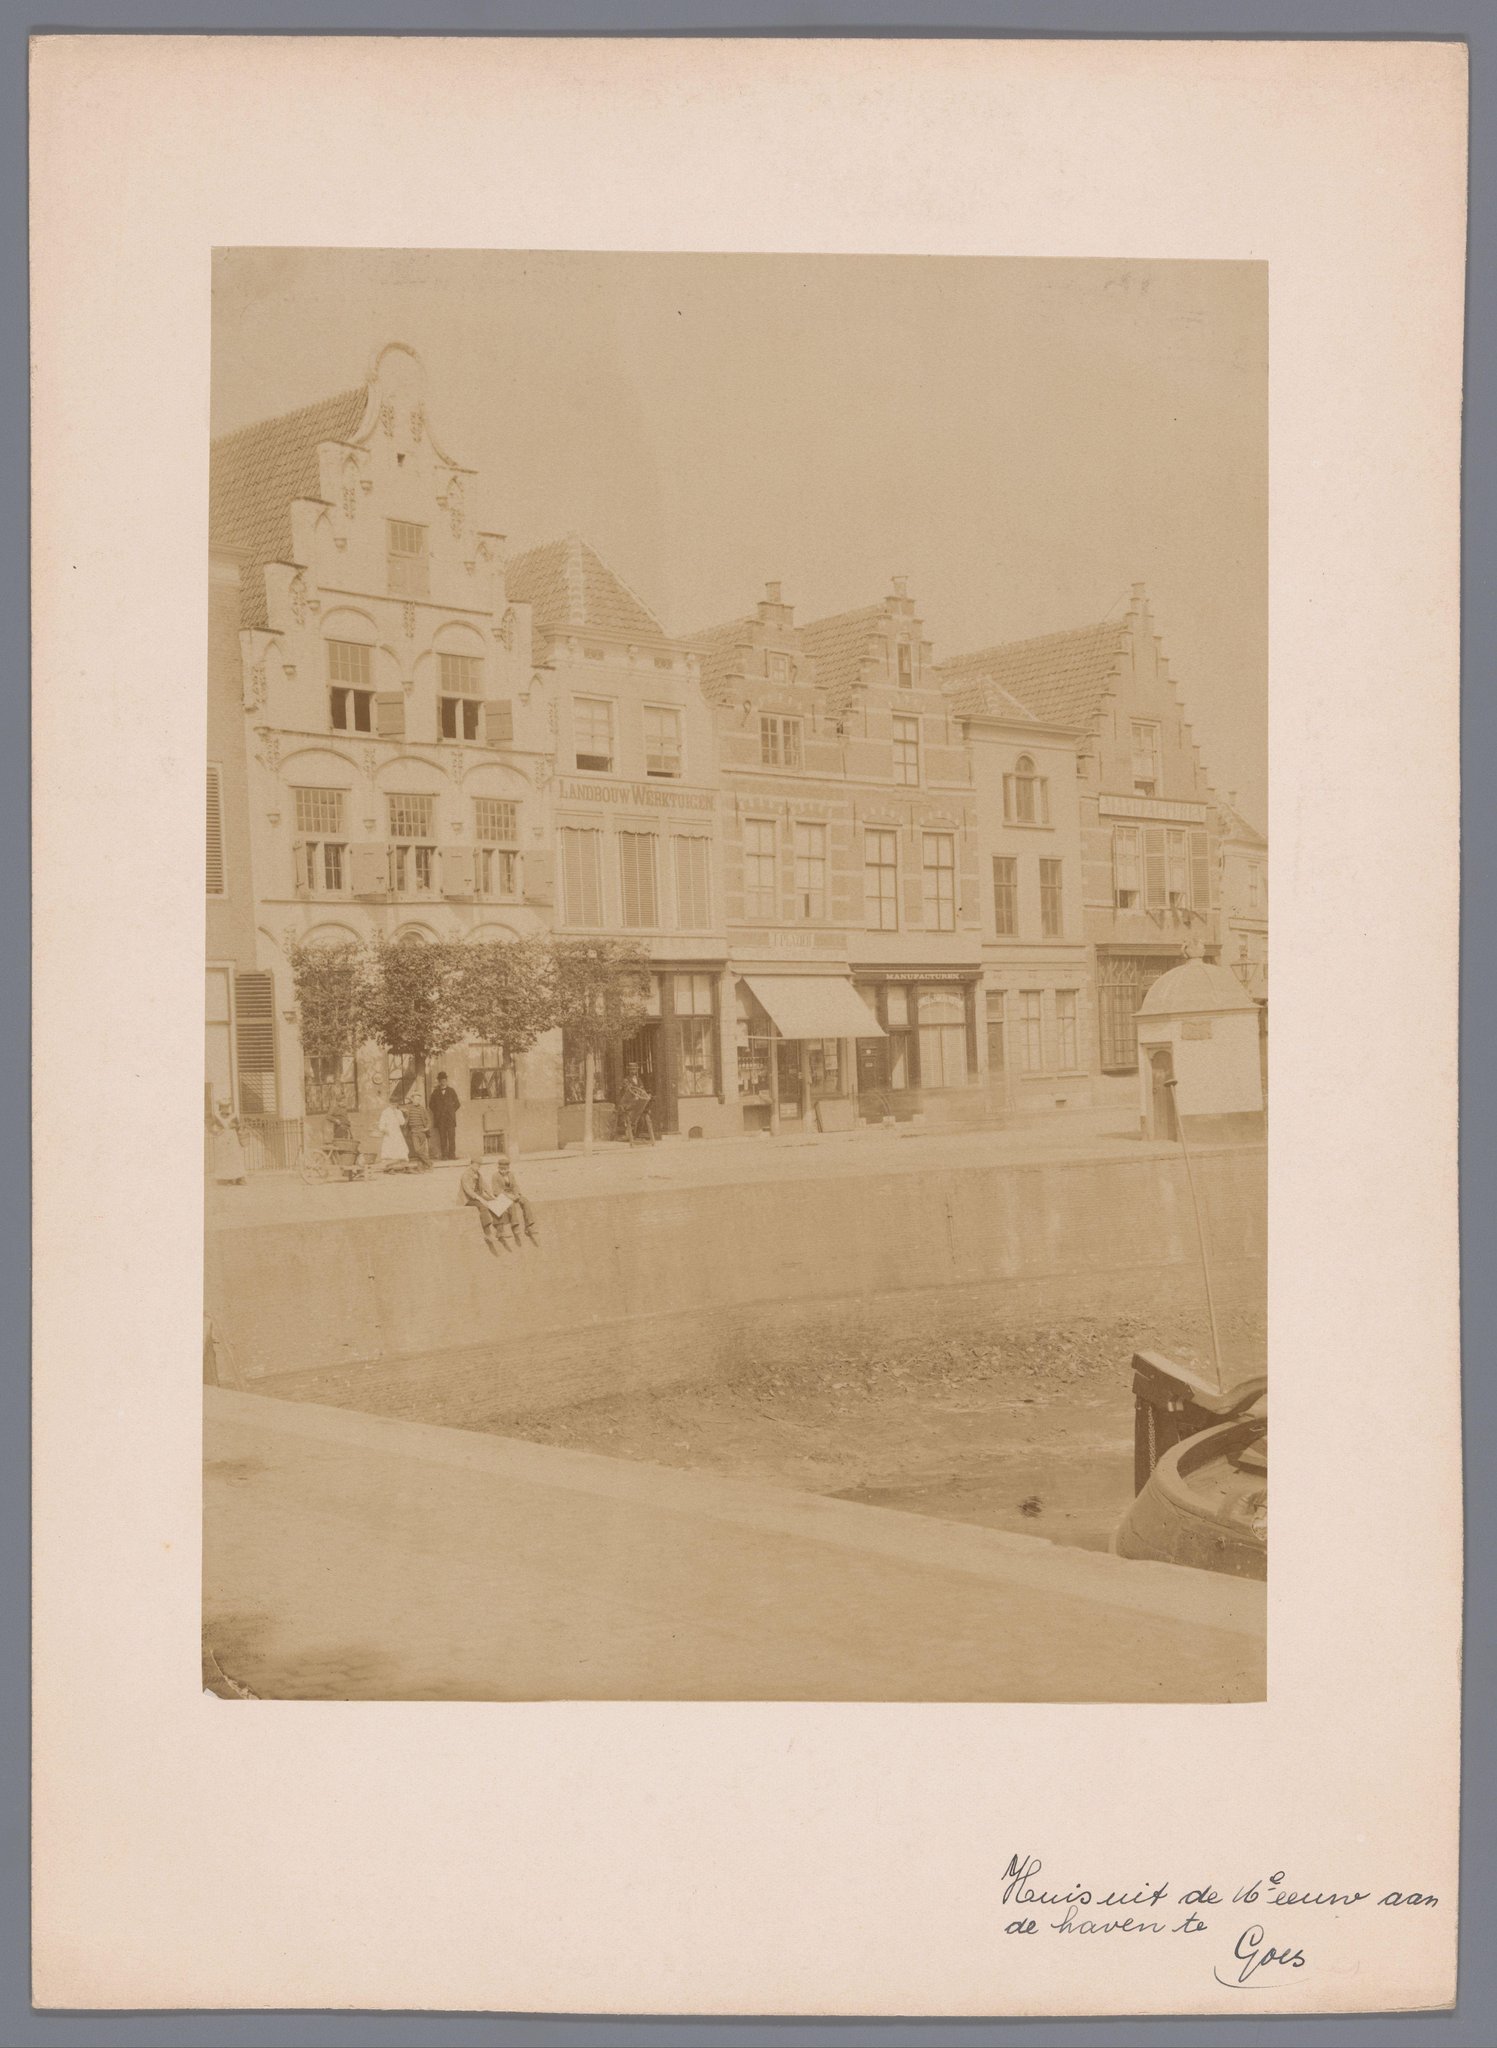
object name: photograph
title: Huizen aan de haven in Goes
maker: anoniem (monumentenzorg)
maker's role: fotograaf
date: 1890-1920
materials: cardboard, photographic support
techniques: albumen print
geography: goes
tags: harbour, urban housing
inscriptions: annotation: ‘Huis uit de 16e eeuw aan de haven te Goes’, annotation: ‘Goes (Z.)/ huis uit de 16de eeuw aan de haven’